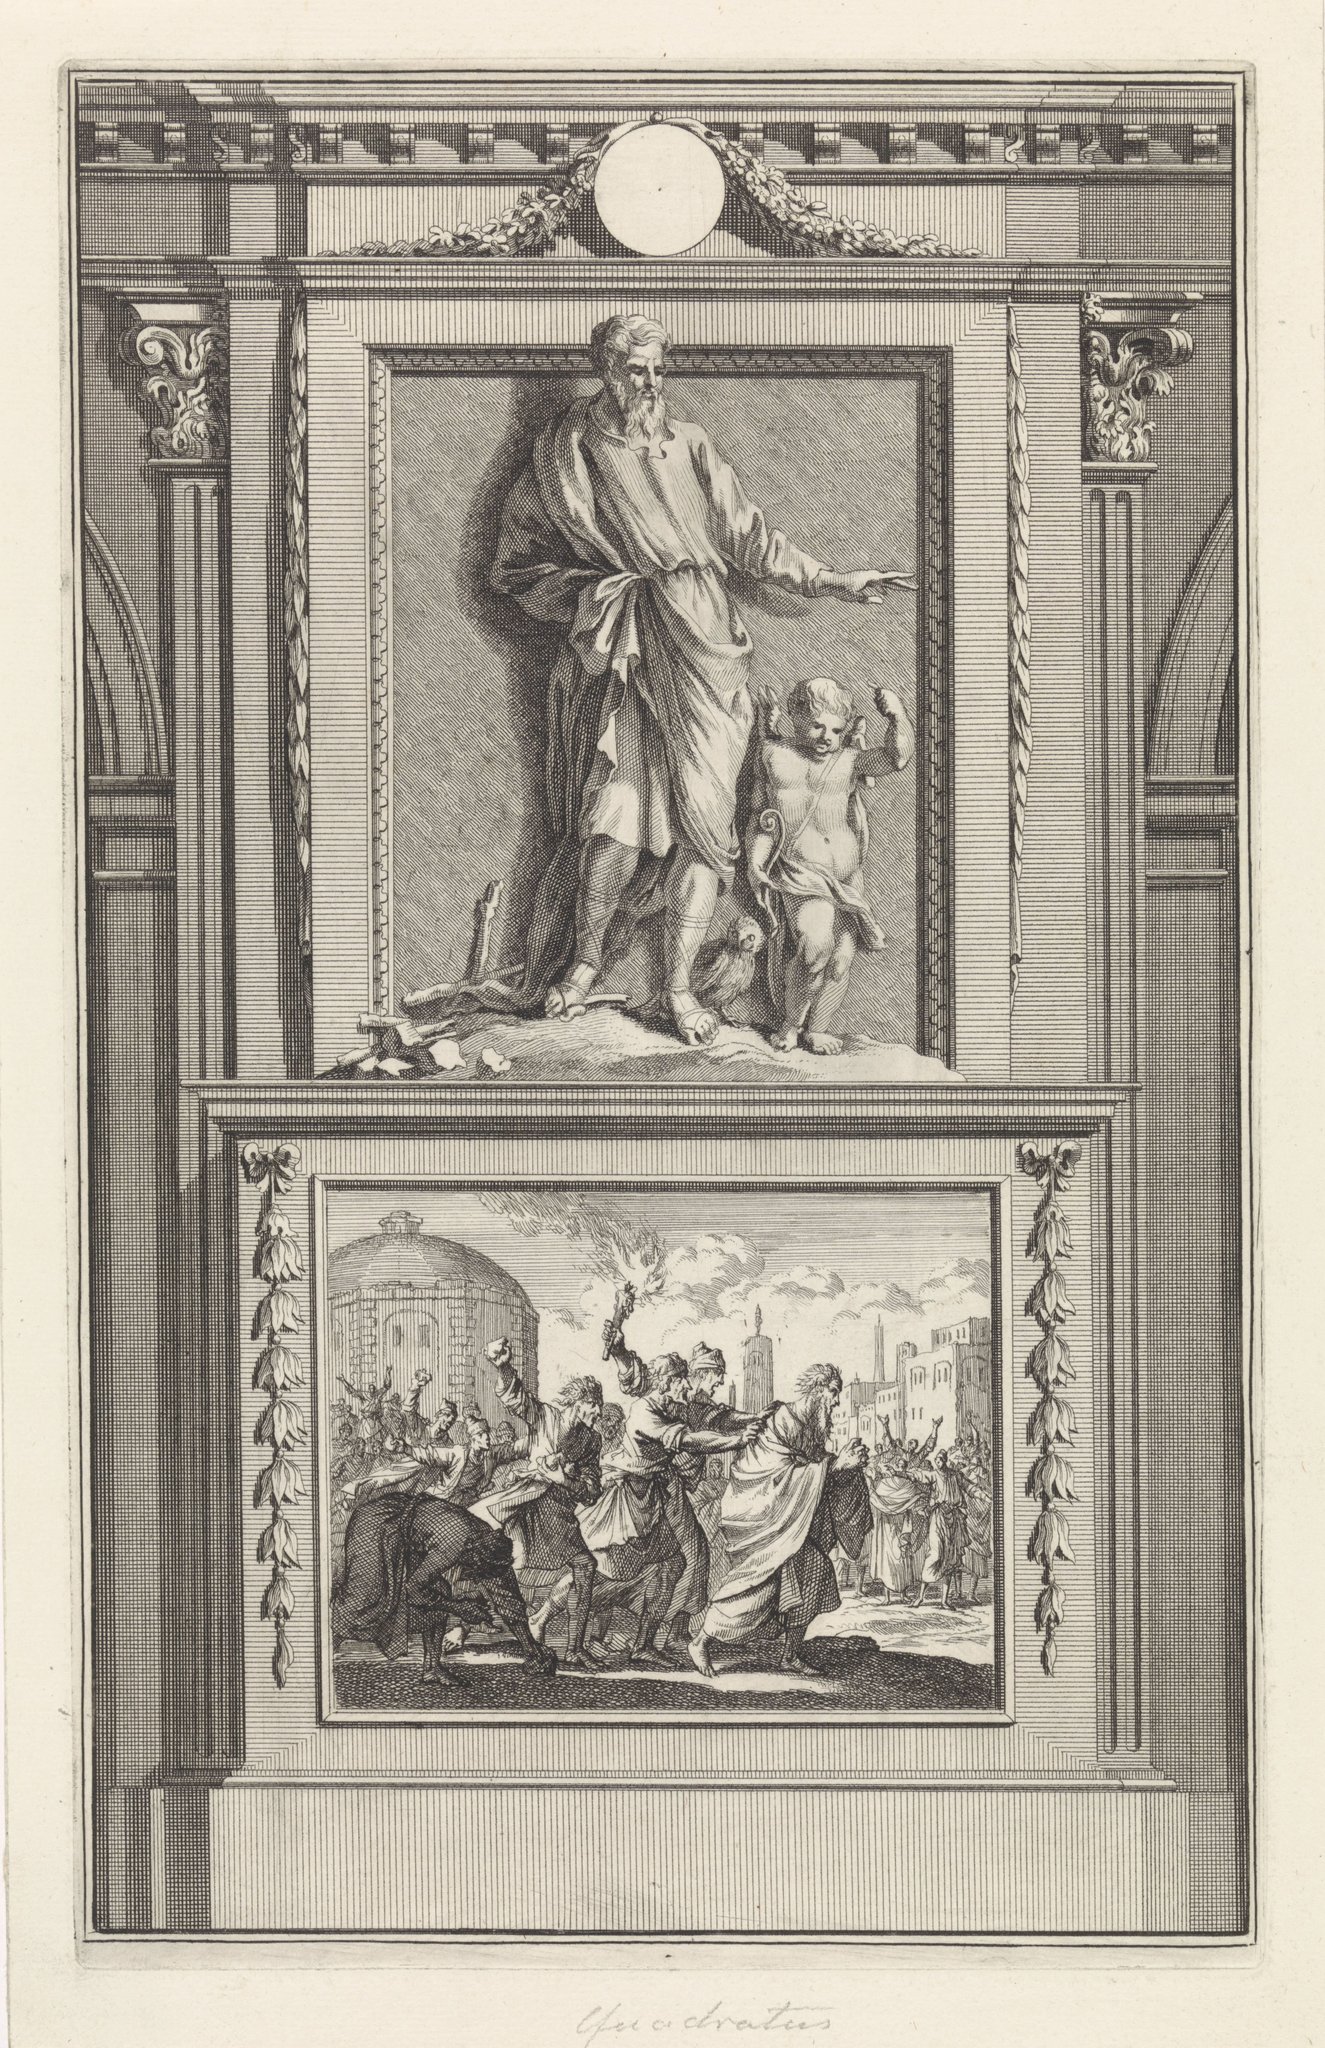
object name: print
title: H. Quadratus van Athene, apologeet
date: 1698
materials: paper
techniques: engraving, etching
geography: amsterdam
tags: male saints (quadratus of athens)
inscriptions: collector's mark: Lugt 2228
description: Proefdruk van illustratie uit: Cave, William. Apostolische oudheden, of Het leven (...) der heylige apostelen, 3 delen. Utrecht: François Halma en Willem van de Water (I), 1698, p. 171.